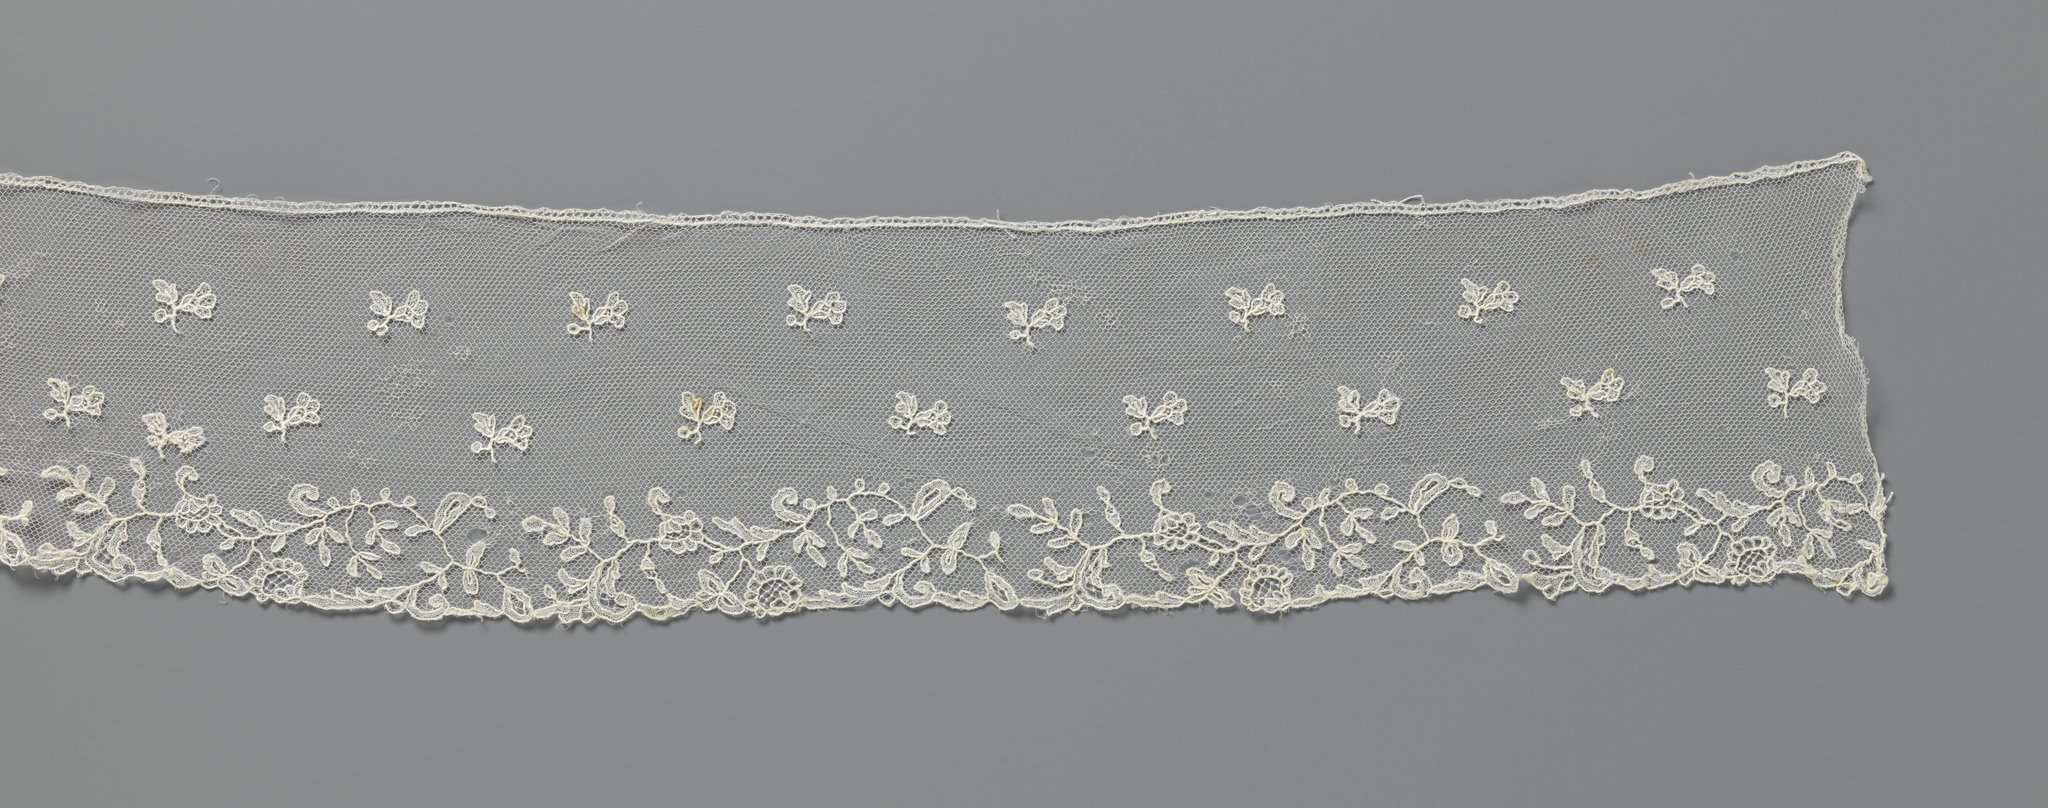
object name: strip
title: Strook applicatiekant met klokjesbloemen en golvende bloemtak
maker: Anonymous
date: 1840-1849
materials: linen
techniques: lace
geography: brussels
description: Strook naturelkleurig Brusselse applicatiekant, naaldkant geappliceerd op machinale tule. Strooipatroon met twee rijen takjes waaraan steeds één klokjesbloem, op een fijne zeshoekige maasgrond. De flauw geschulpte onderrand komt voort uit het repetitief motief van een golvende bladertak waaraan twee bloemen en een bloemknop. Motieven met reliëfcontouren van wijd gefestonneerde draadbundels. Siersteken in de bloemen en bloemknoppen en tussen enkele bladeren. De bovenzijde is afgewerkt met een geklost bandje.